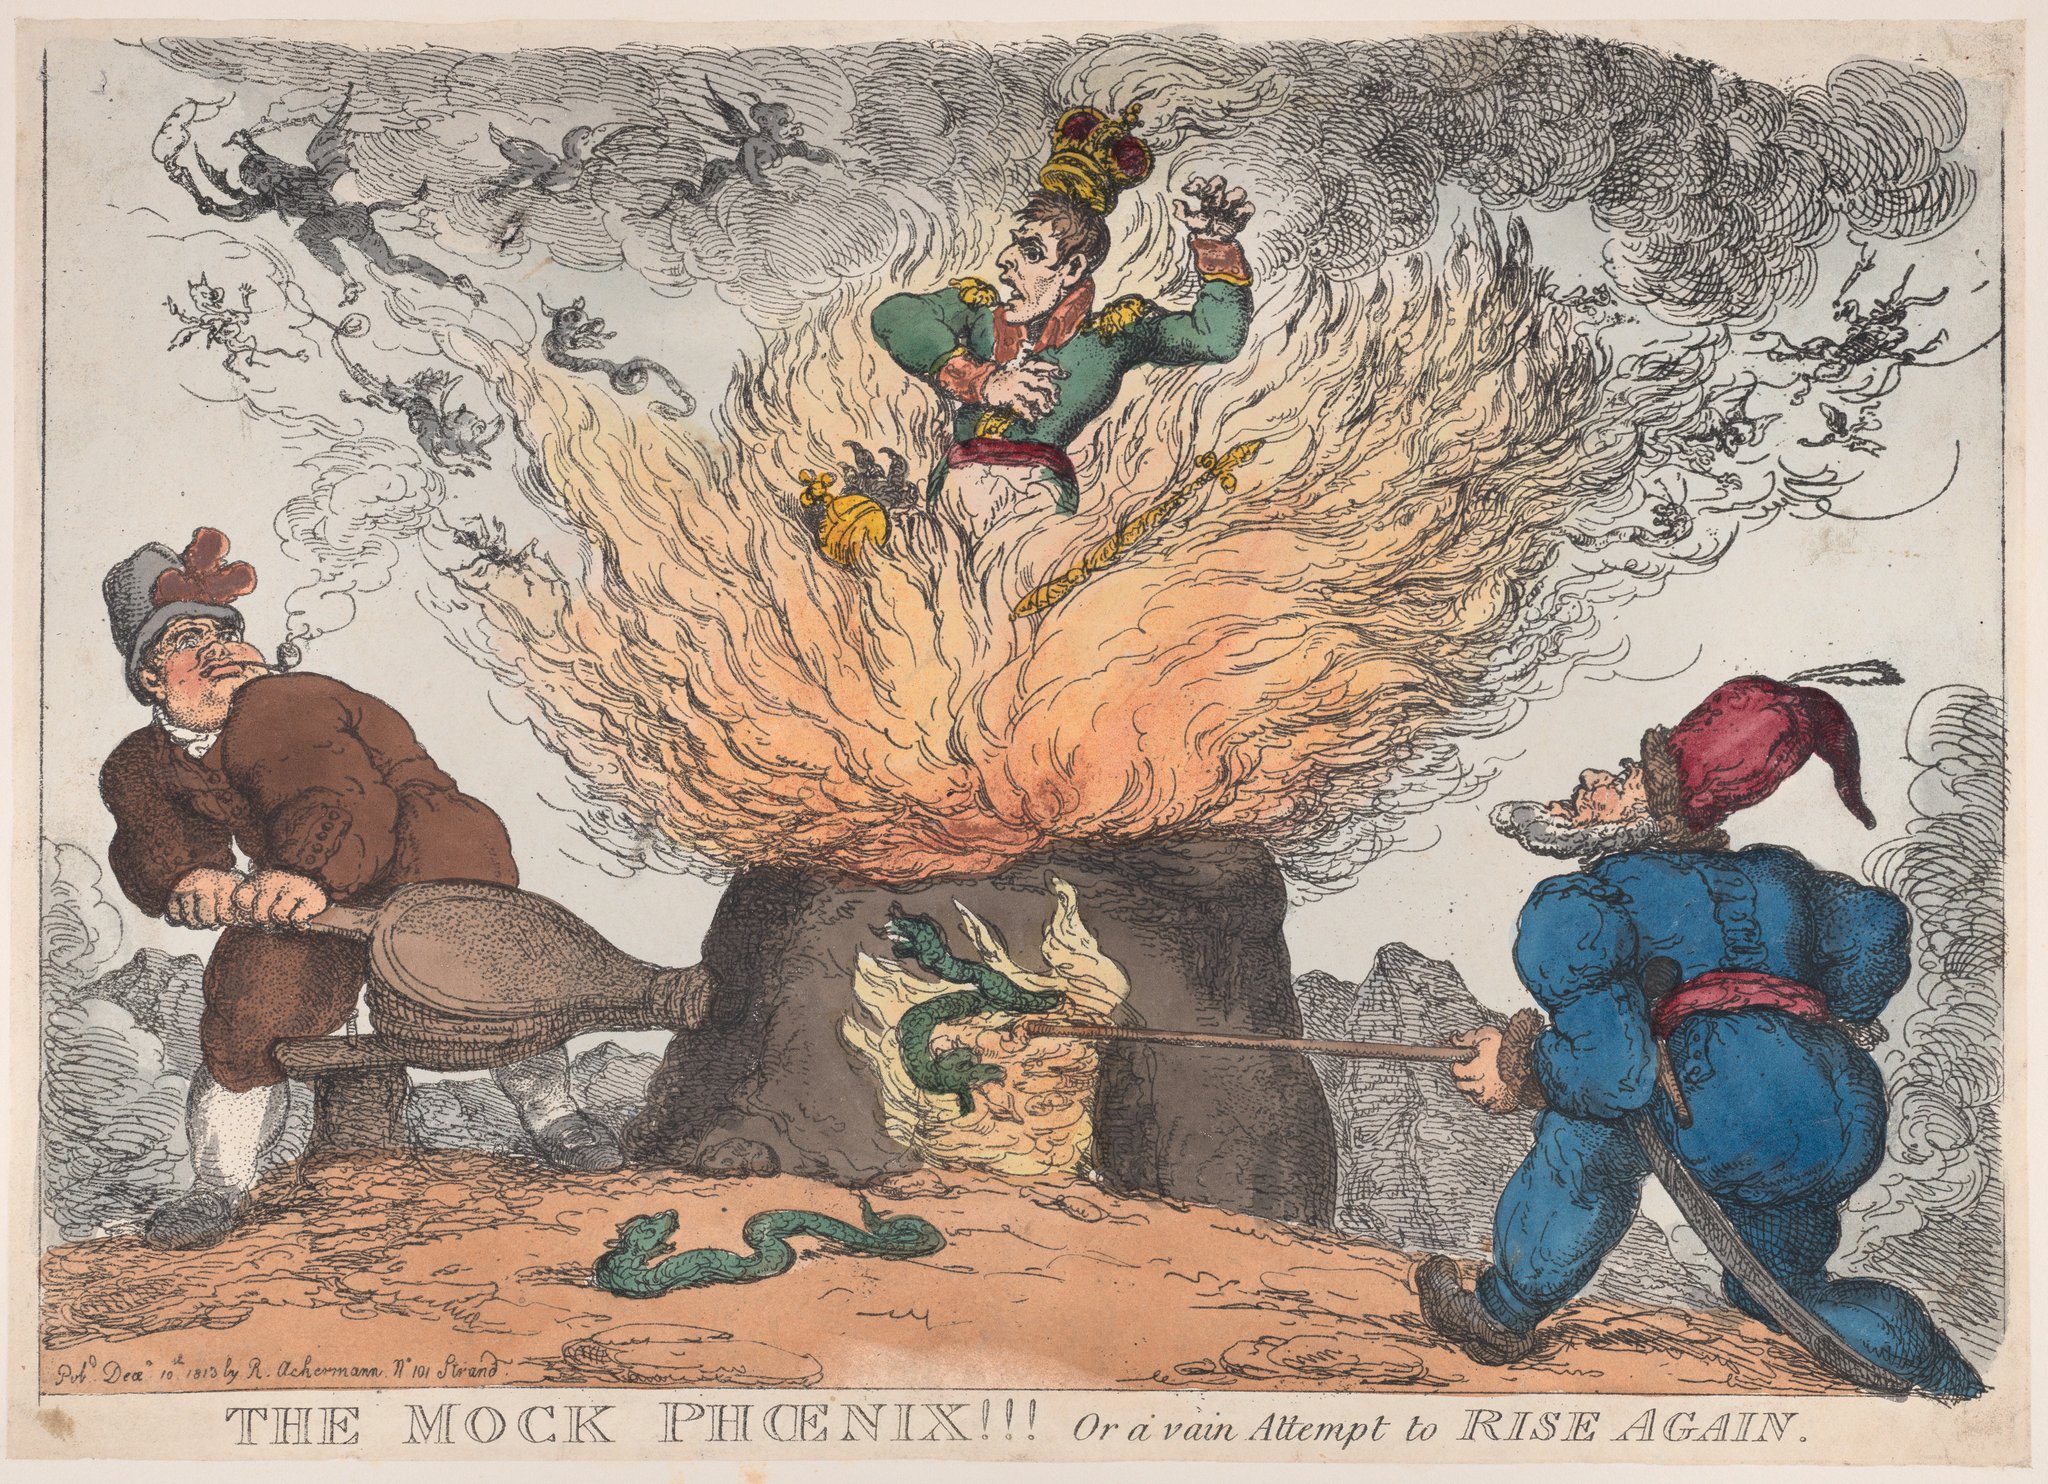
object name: print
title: The Mock Phoenix!!! Or a Vain Attempt to Rise Again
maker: thomas rowlandson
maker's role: artist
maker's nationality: british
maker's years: 1757-1827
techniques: etching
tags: satire,napoleon i,men,snakes,fire,politics